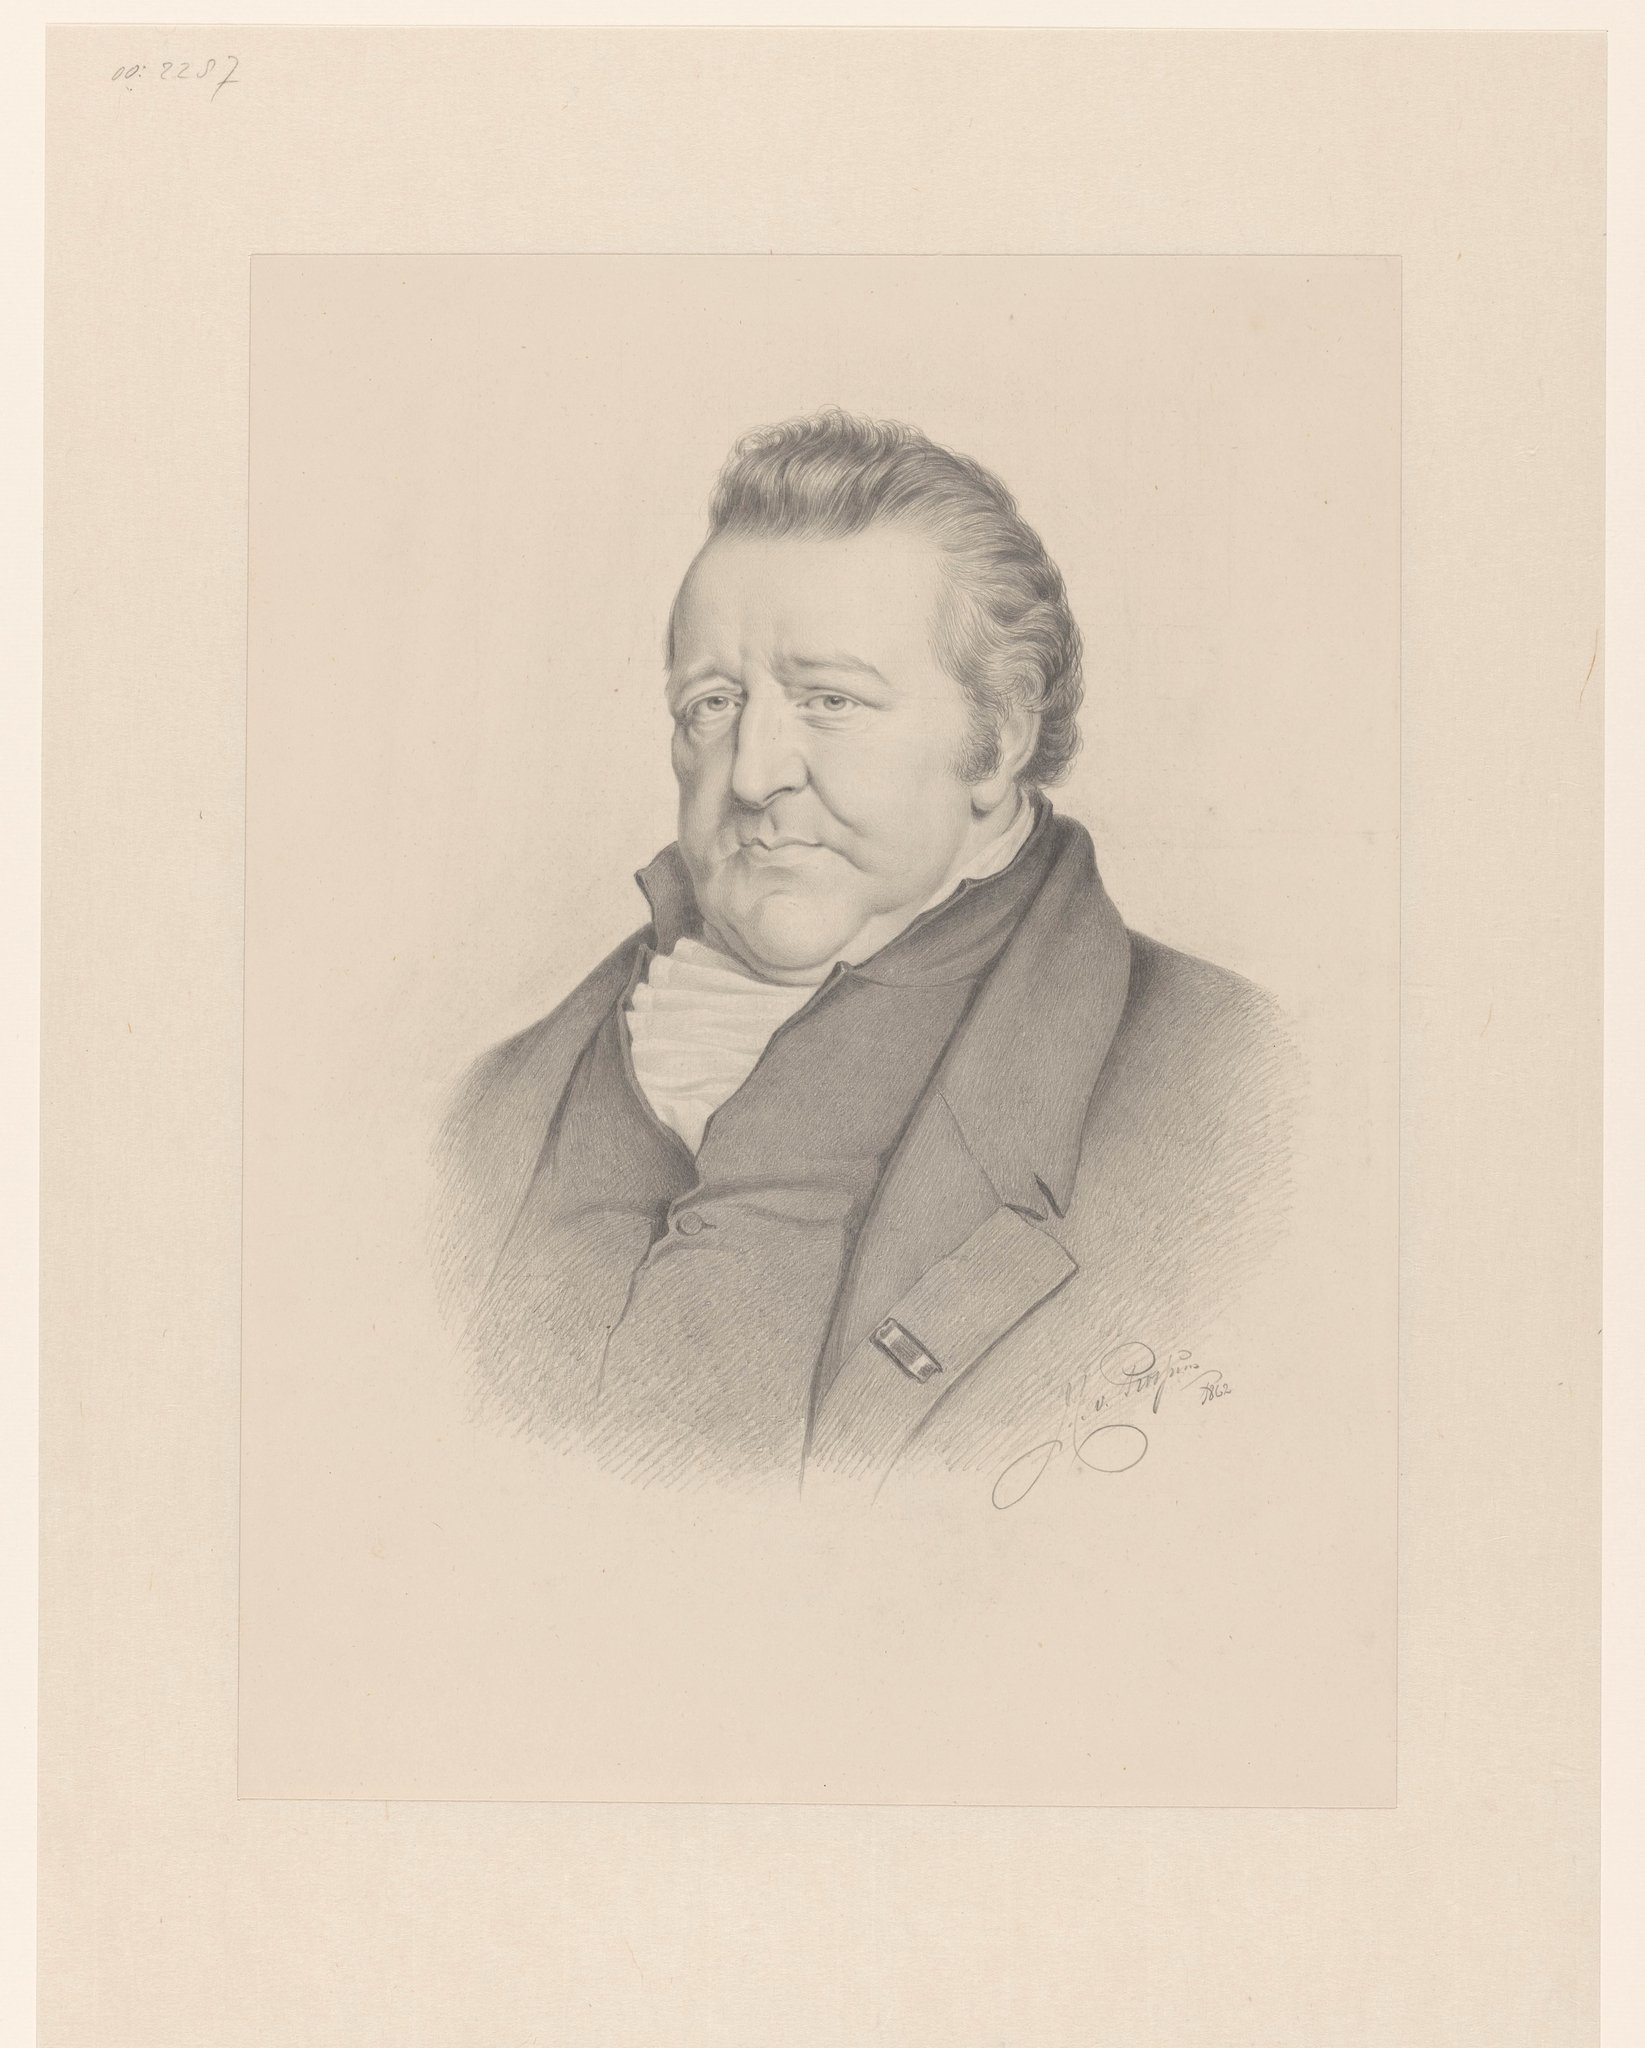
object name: drawing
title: Portret van Jan Schouten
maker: jan cornelis van rossum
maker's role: draughtsman, painter, print maker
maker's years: 1820-1905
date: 1862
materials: paper, pencil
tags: jan schouten, historical persons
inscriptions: date: ‘1862’